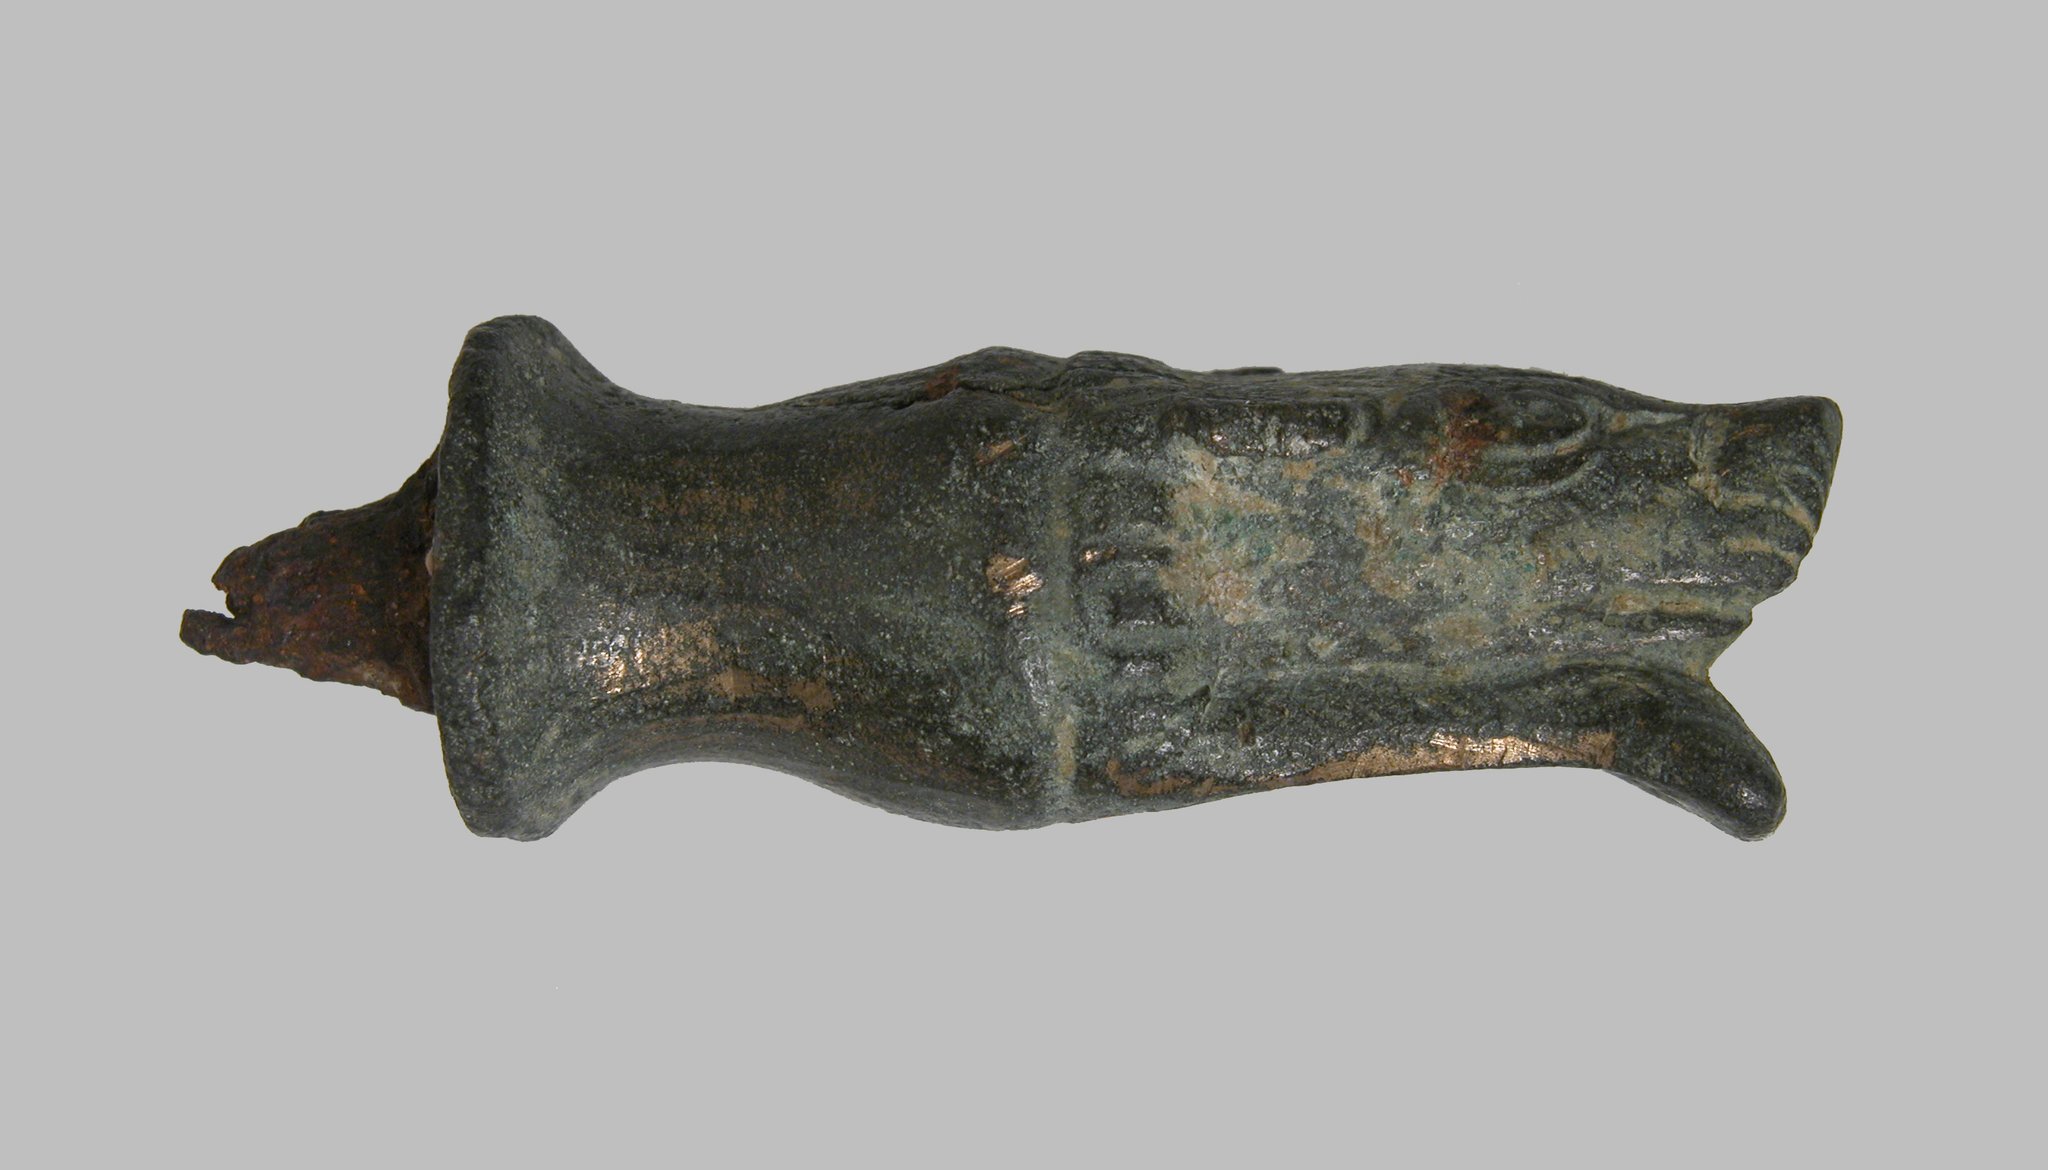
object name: key handle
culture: roman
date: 1-700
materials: copper alloy, iron